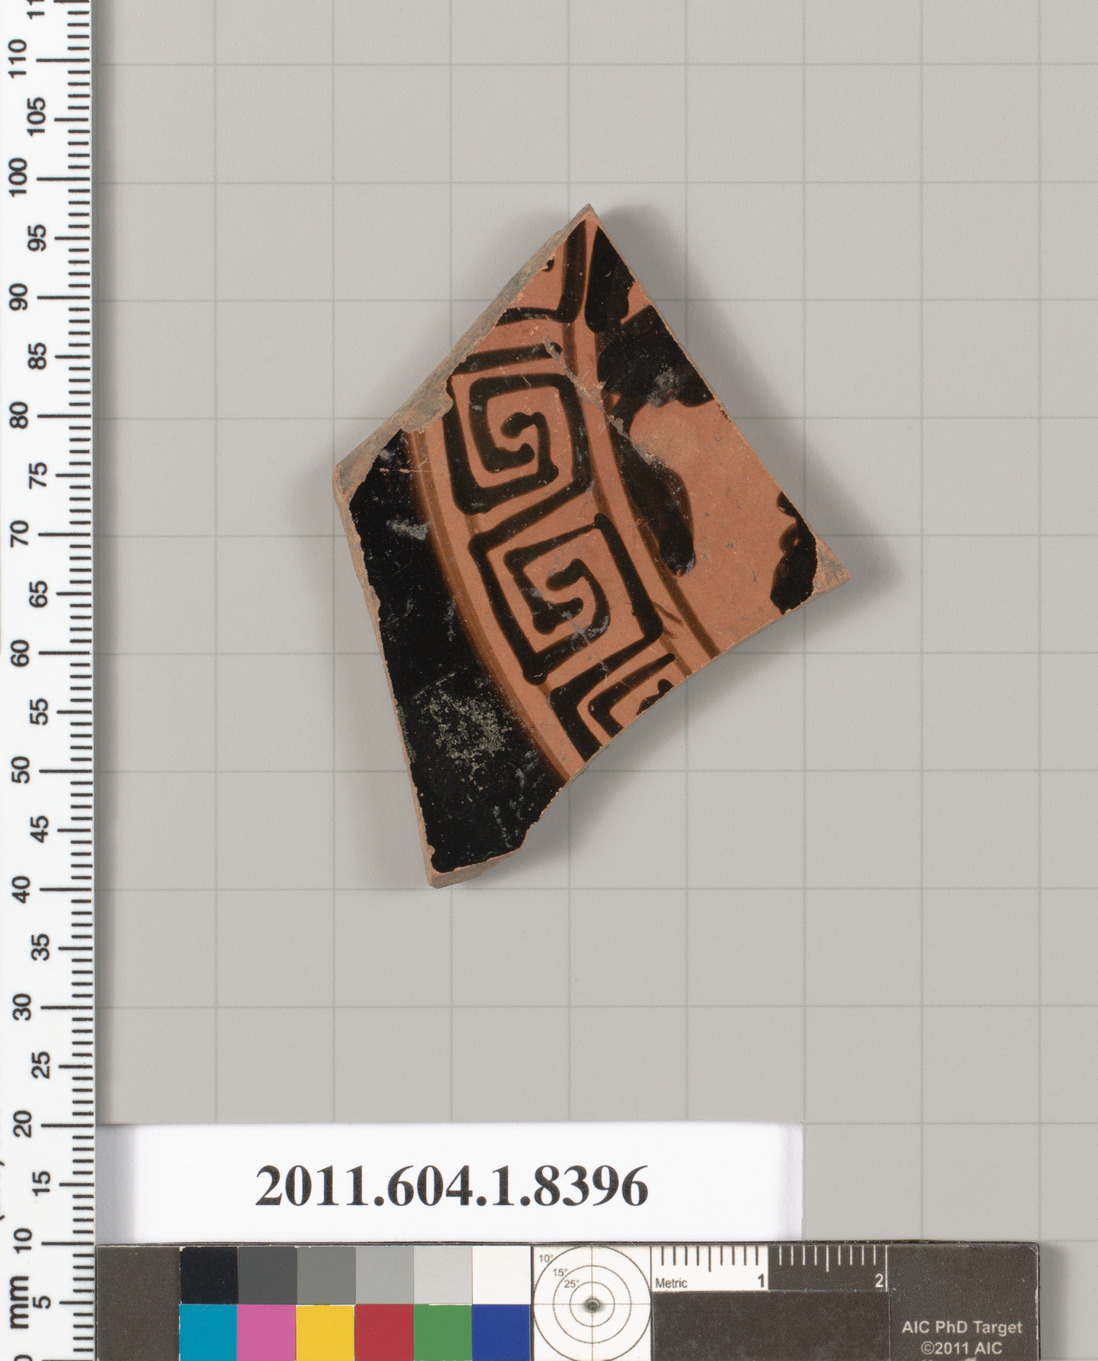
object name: kylix fragment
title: Terracotta fragment of a kylix (drinking cup)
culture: greek, attic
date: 400-351 BCE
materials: terracotta